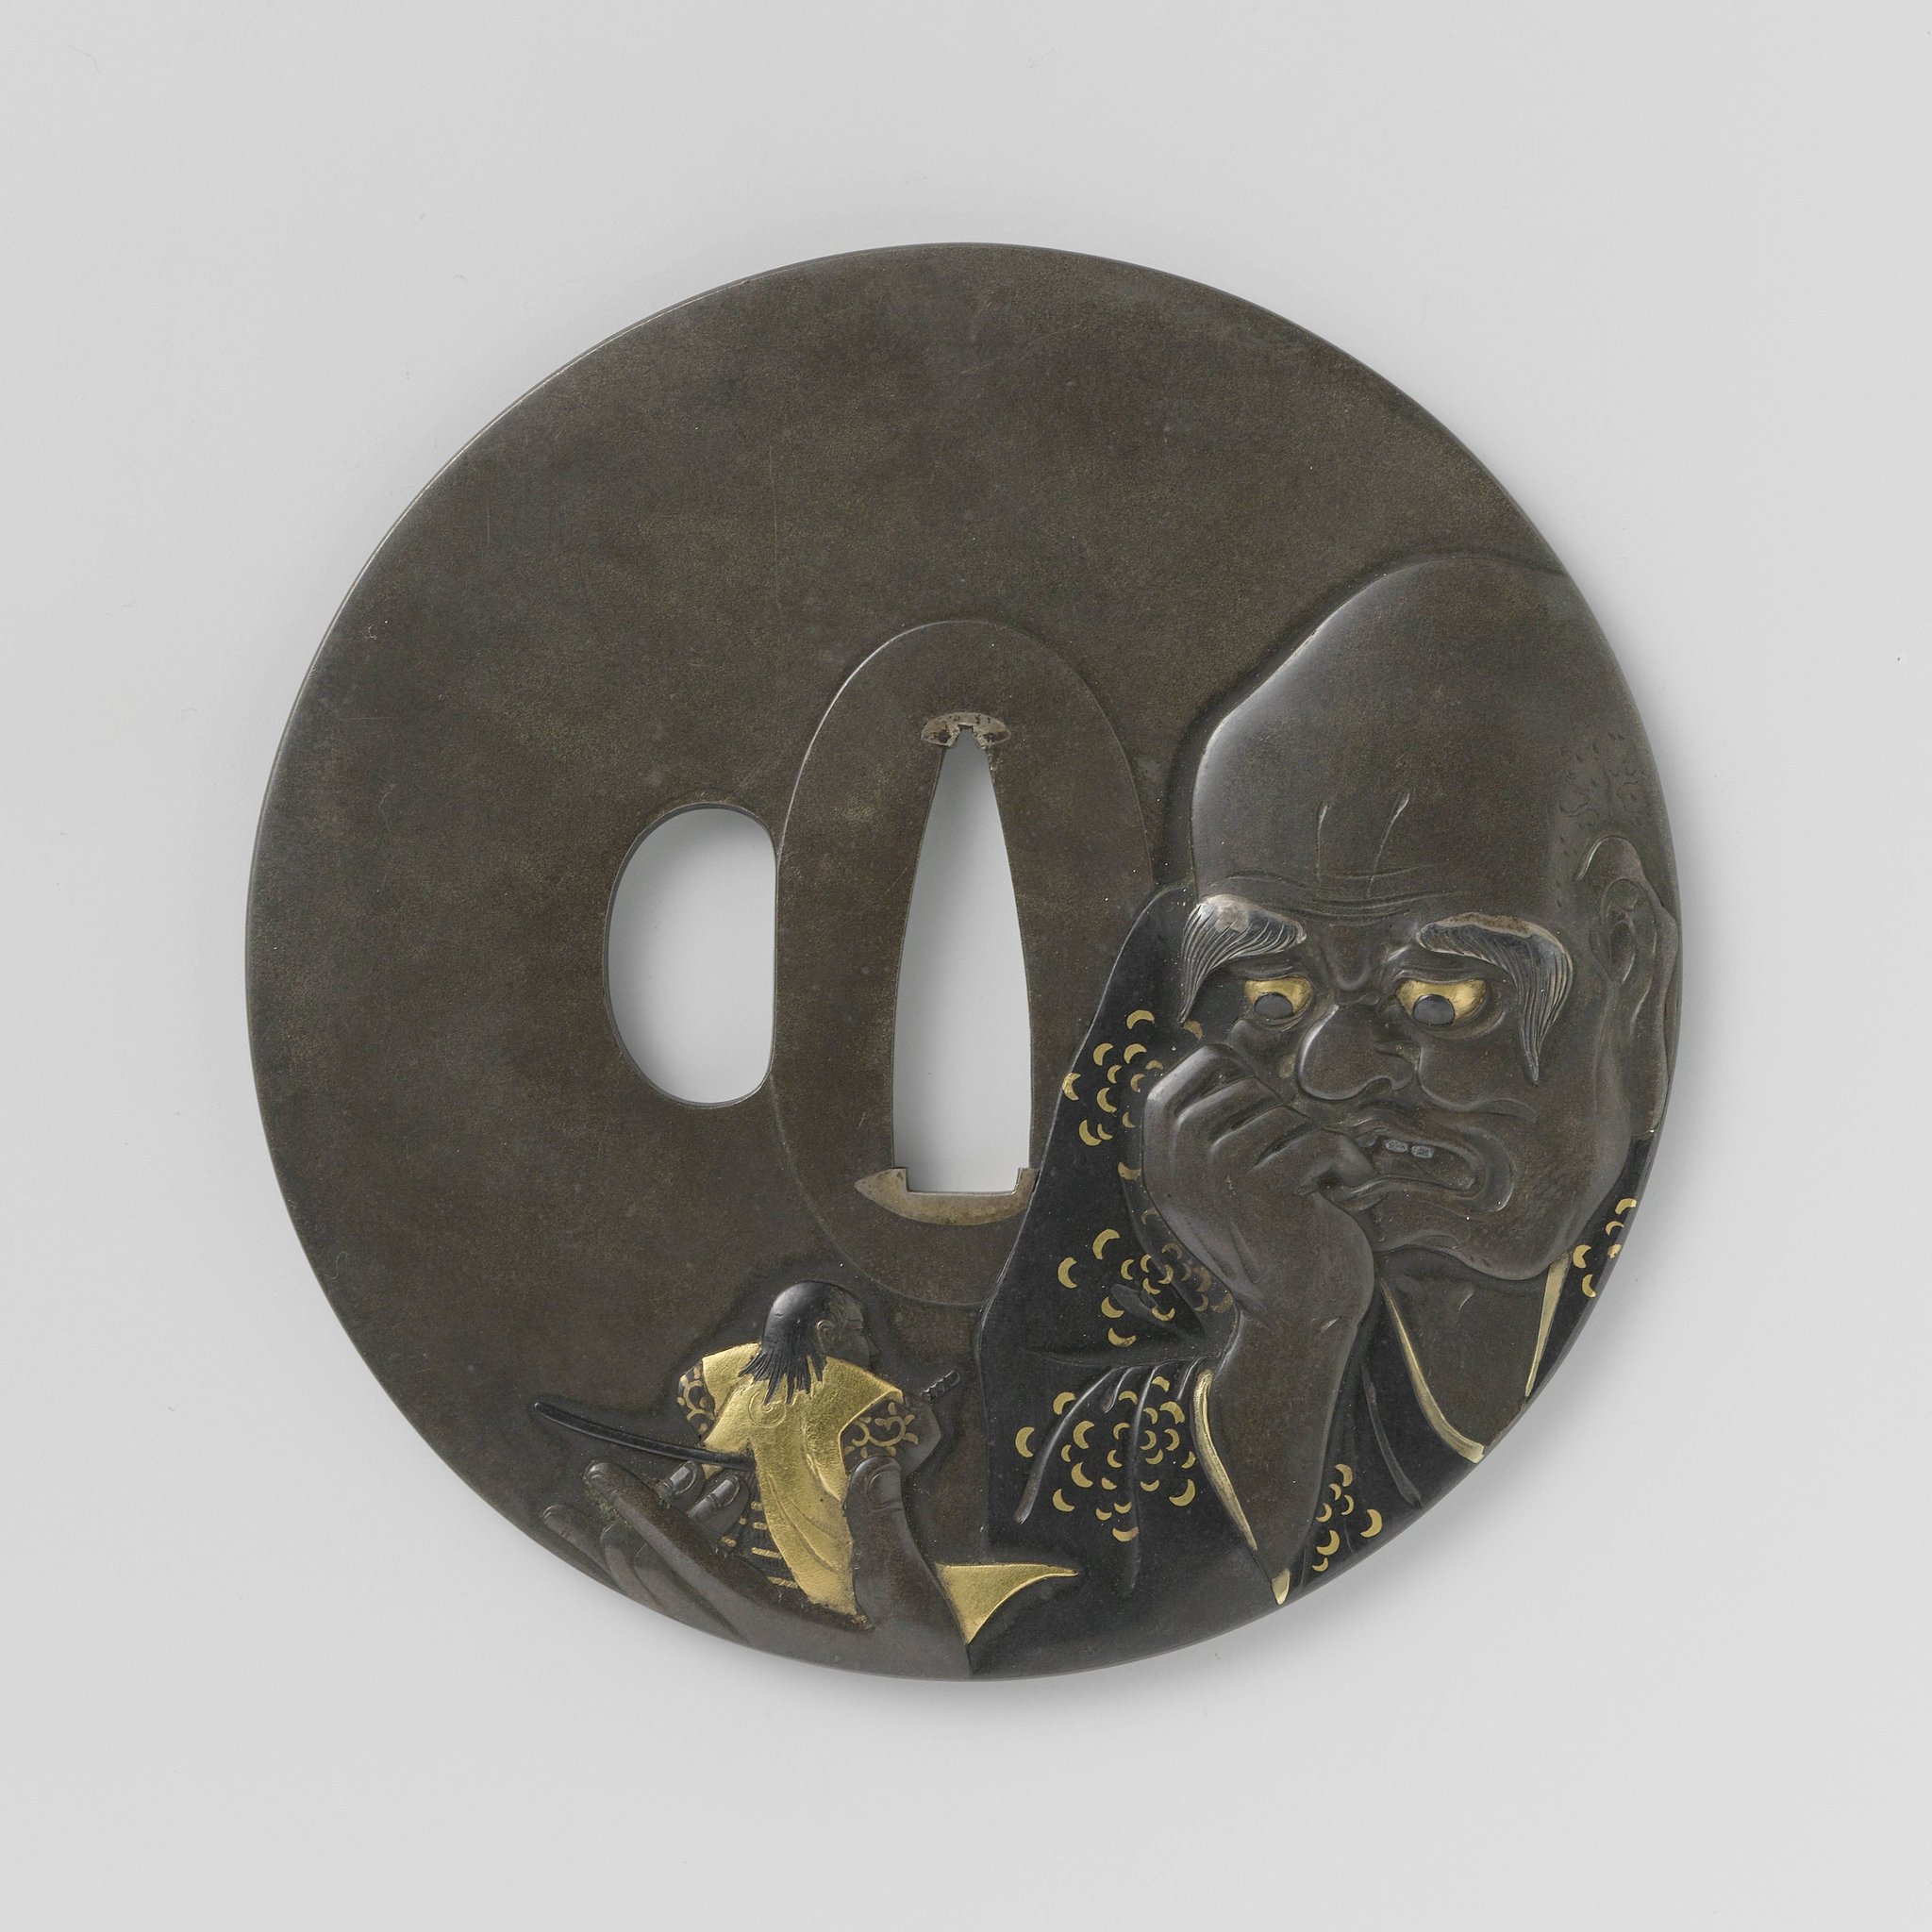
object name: tsuba, zwaardstootplaat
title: Hand guard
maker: hata nobuyoshi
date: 1800-1900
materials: copper, gold, silver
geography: japan